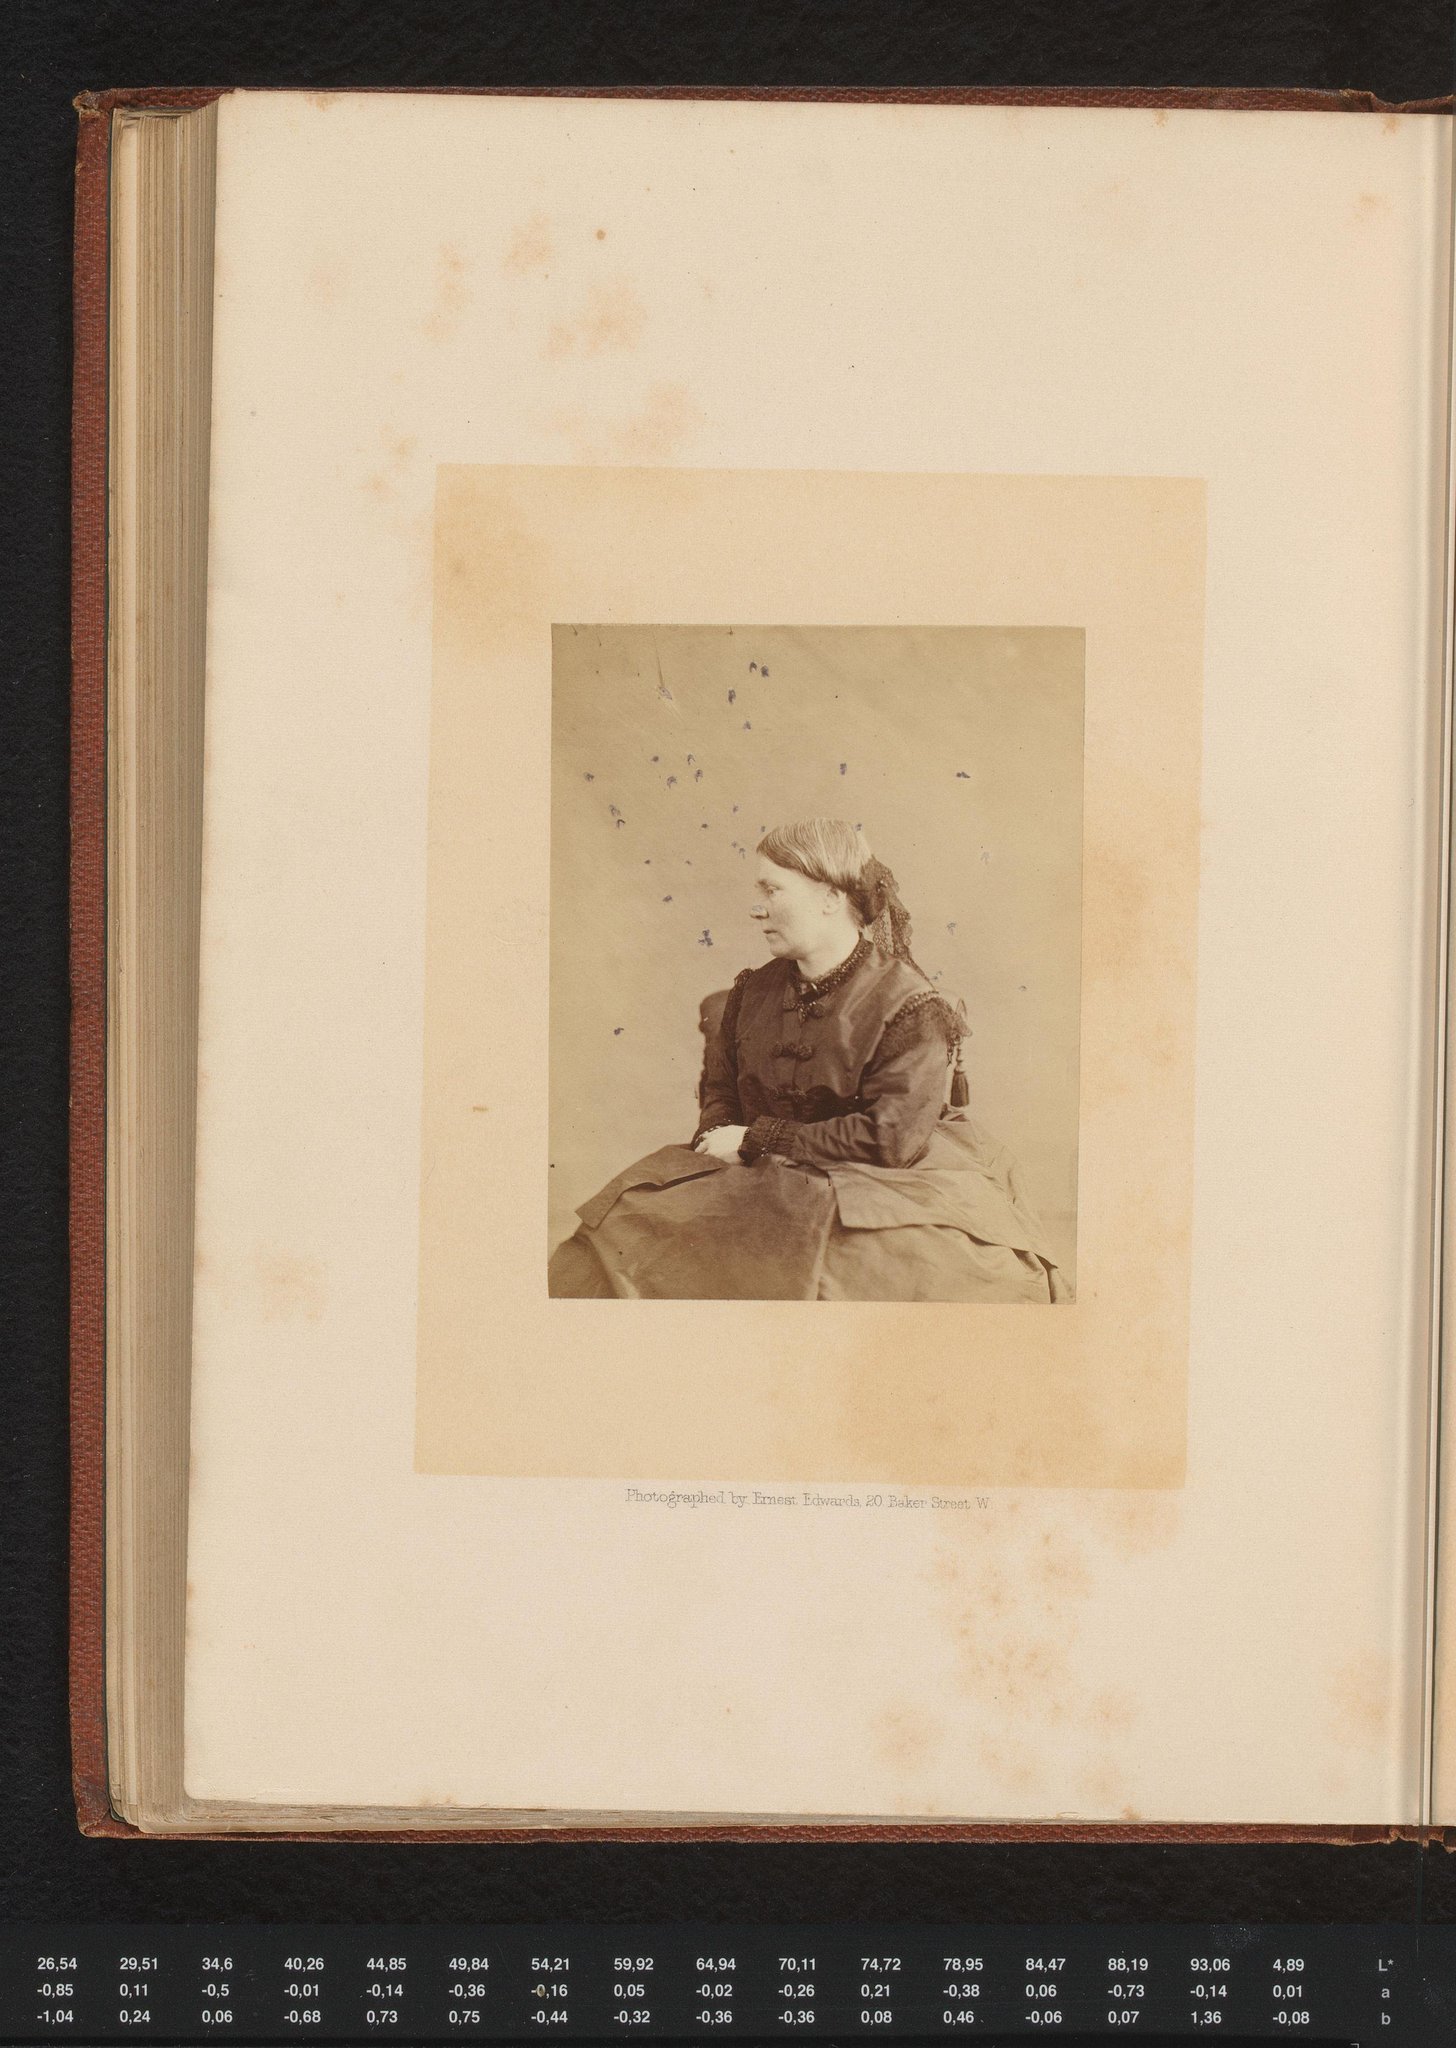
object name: page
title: Portret van de abolitioniste Elizabeth Blackwell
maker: ernest edwards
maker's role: fotograaf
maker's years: 1837-1903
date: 1861-1866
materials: paper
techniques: albumen print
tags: historical persons - bb - woman